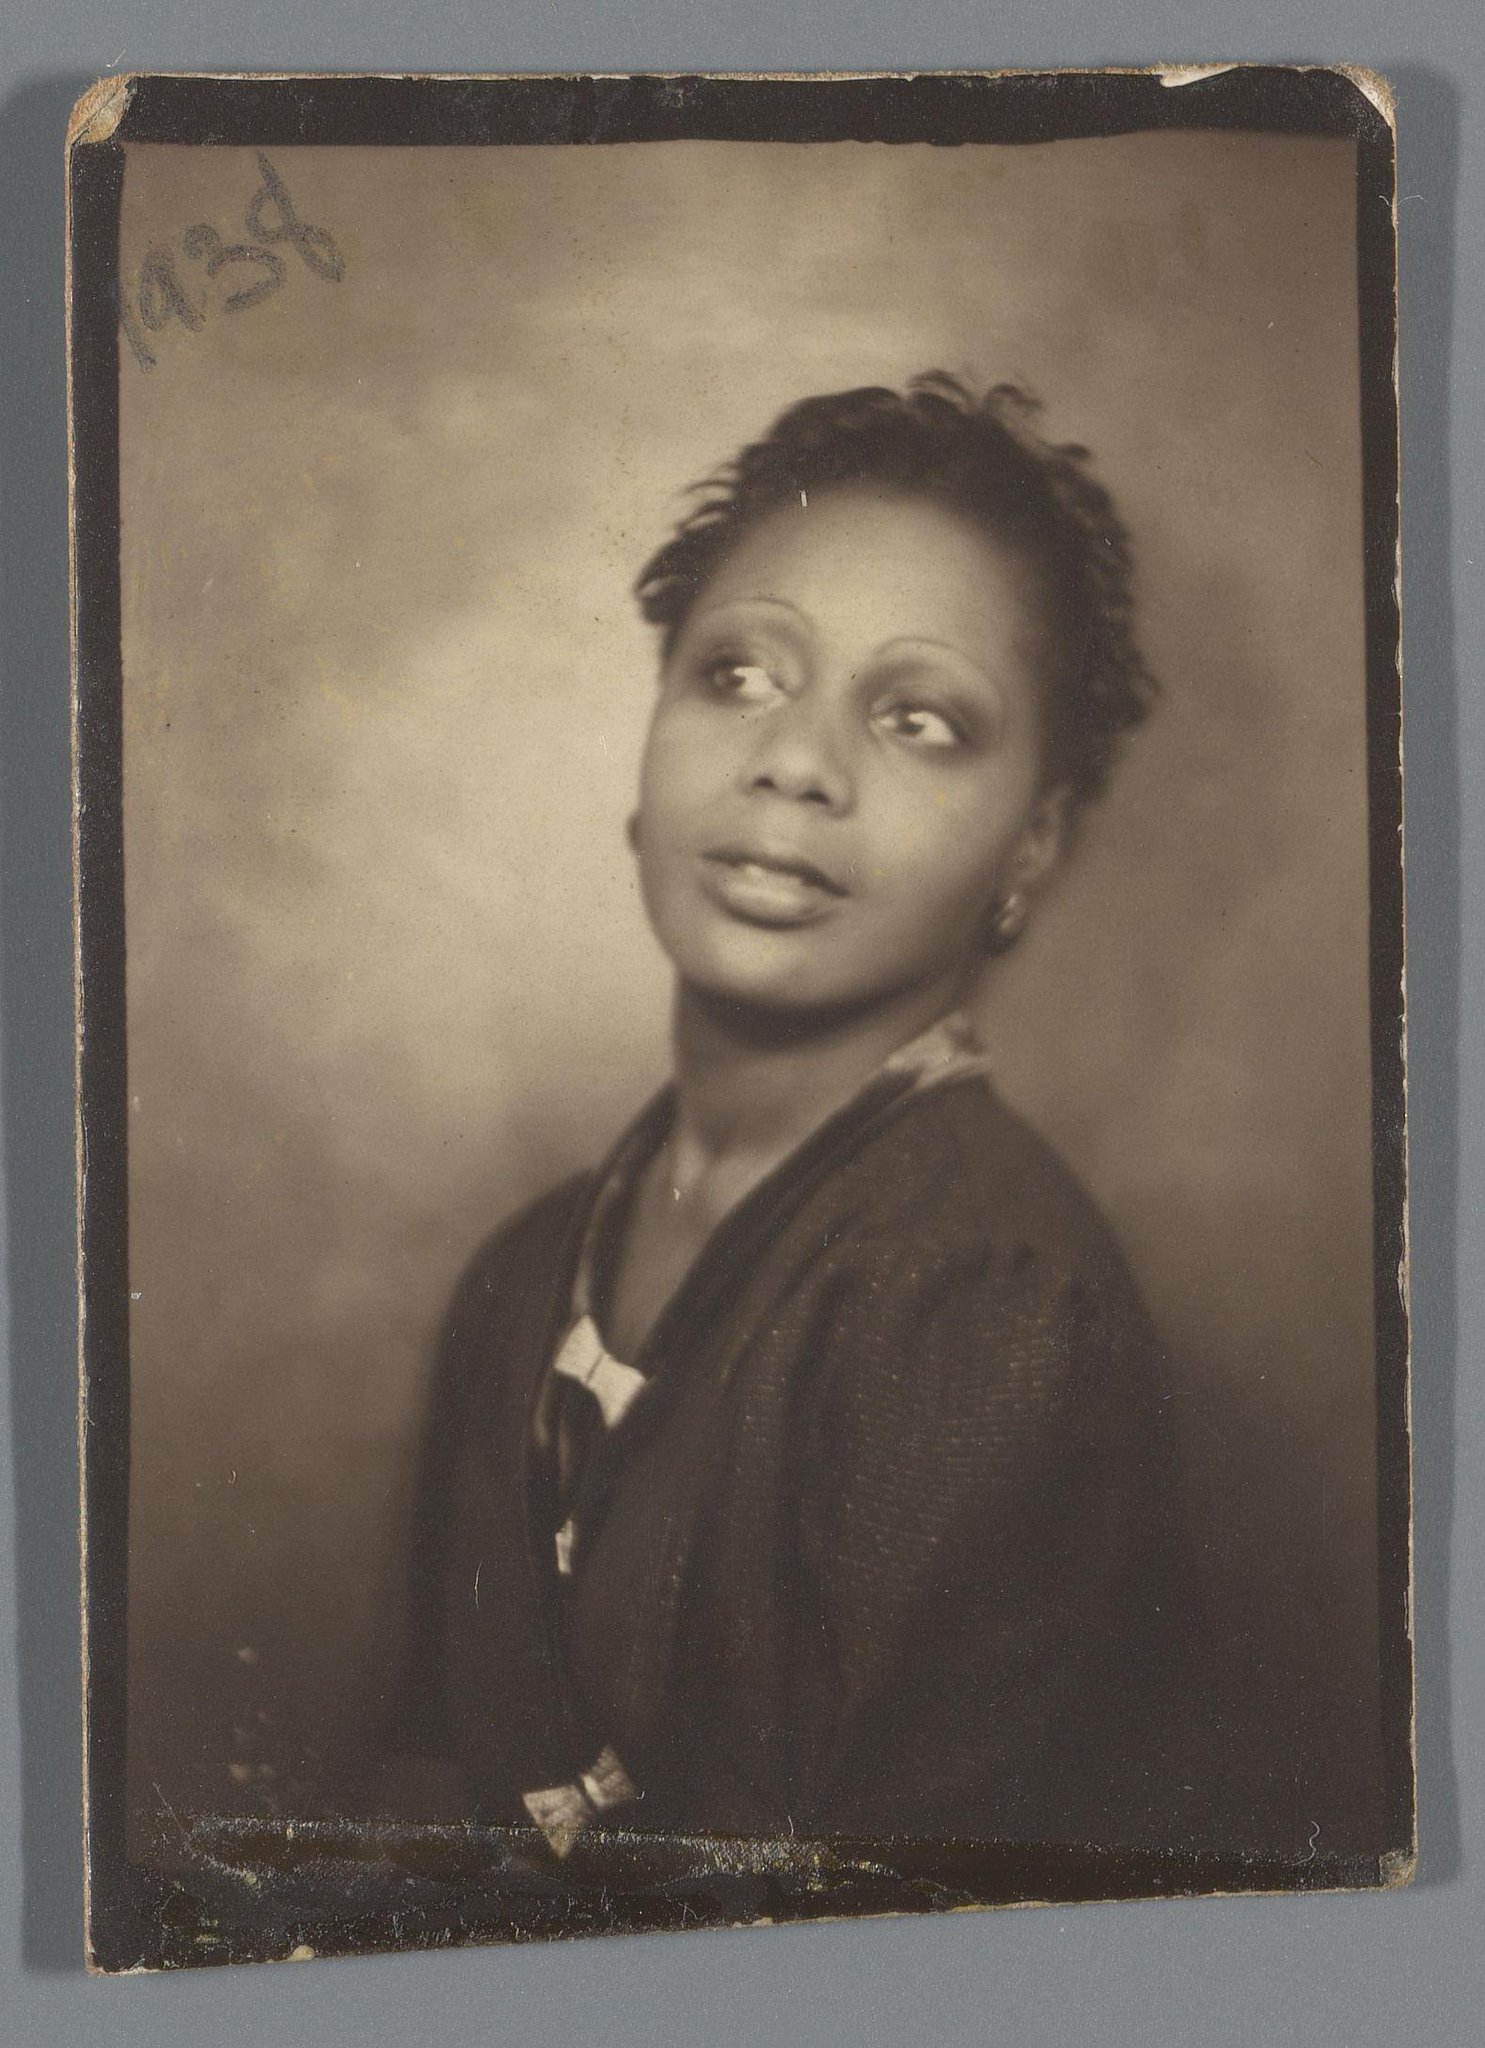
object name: photograph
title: Portret van een Zwarte Amerikaanse vrouw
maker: Anonymous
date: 1938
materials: photographic support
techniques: gelatin silver print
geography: united states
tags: united states of america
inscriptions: inscription: ‘1938’